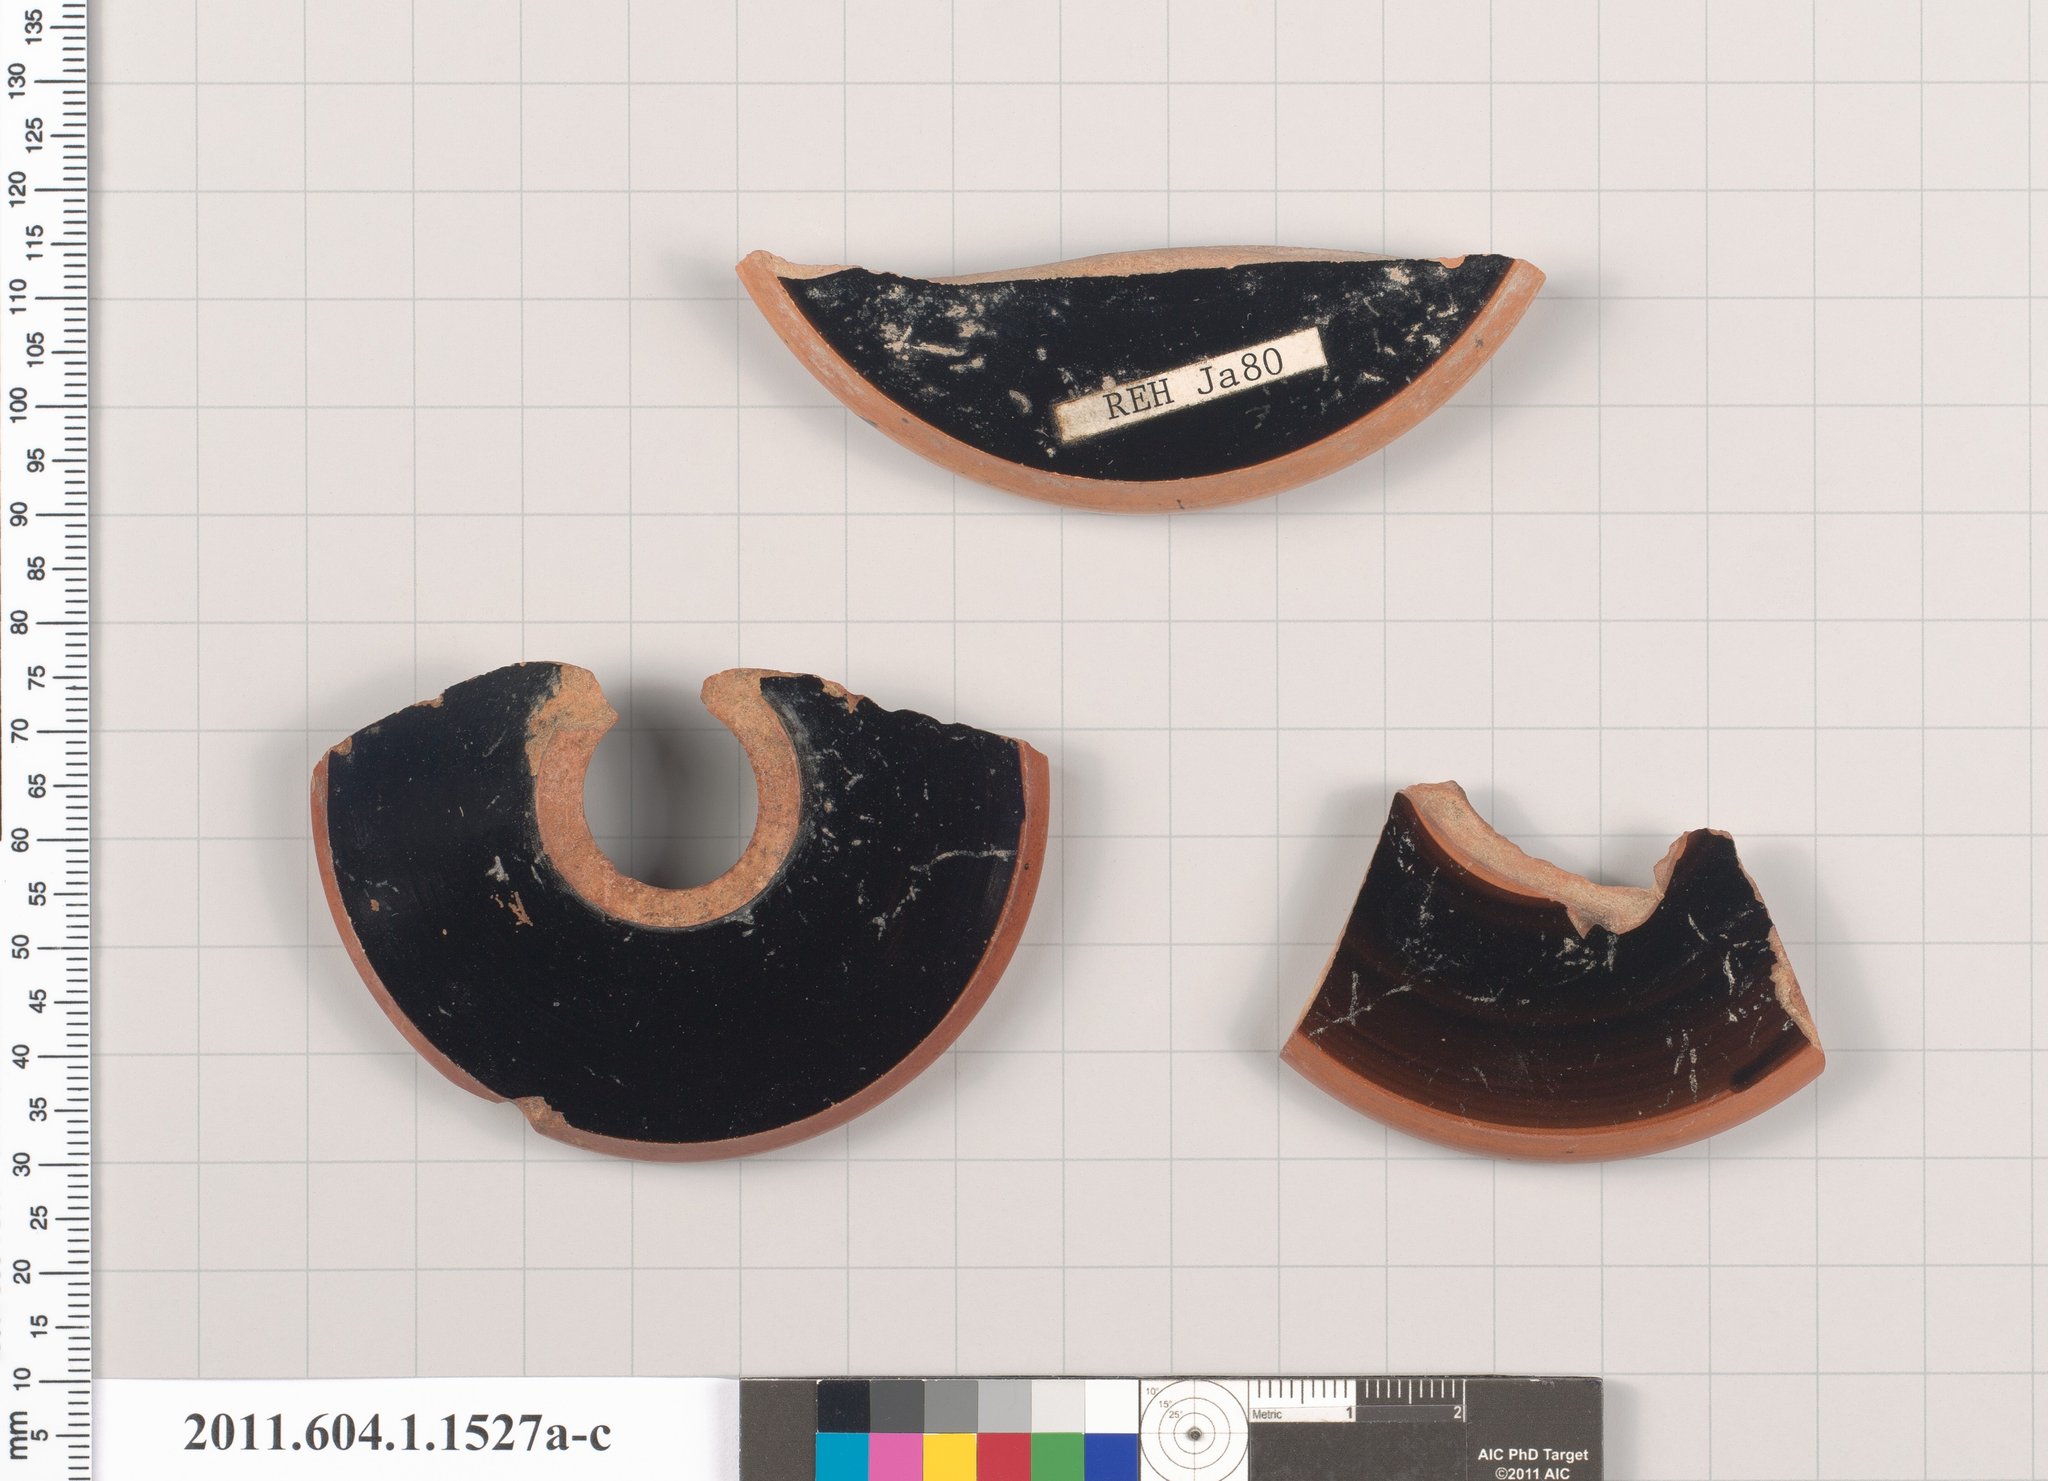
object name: kylix fragment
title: Terracotta fragments of kylikes (drinking cups)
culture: greek, attic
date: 500-401 BCE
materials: terracotta